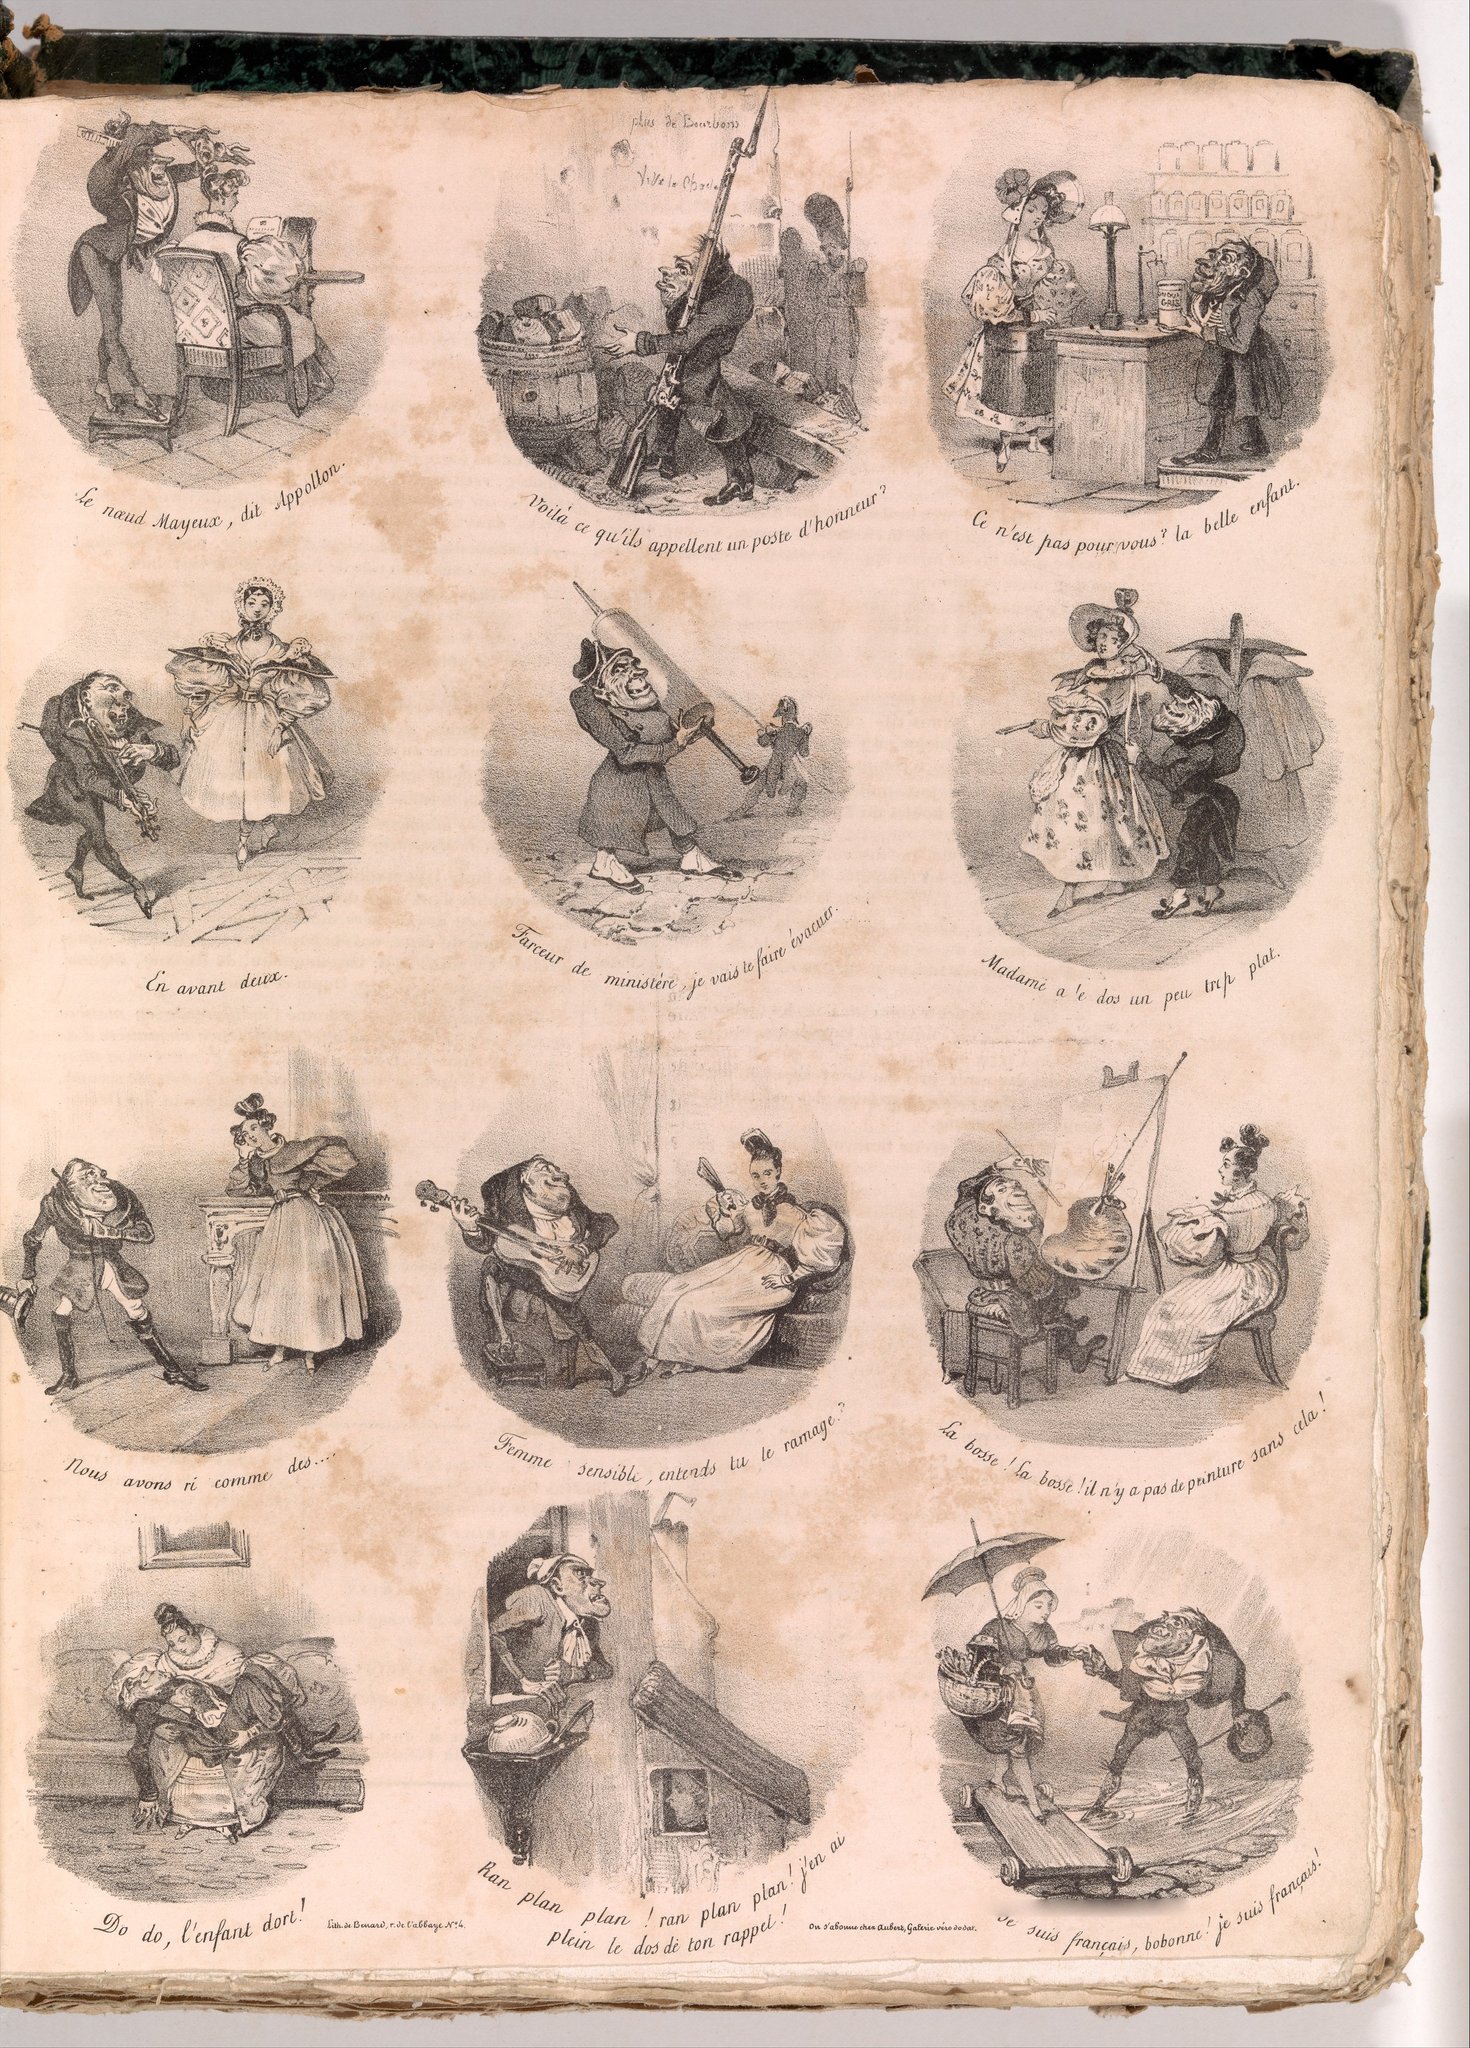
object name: book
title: Le Charivari, December 1, 1832–May 31, 1833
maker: honoré daumier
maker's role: artist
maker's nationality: french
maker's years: 1808-1879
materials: wood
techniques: engraving, lithograph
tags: musical instruments,satire,men,women,caricature